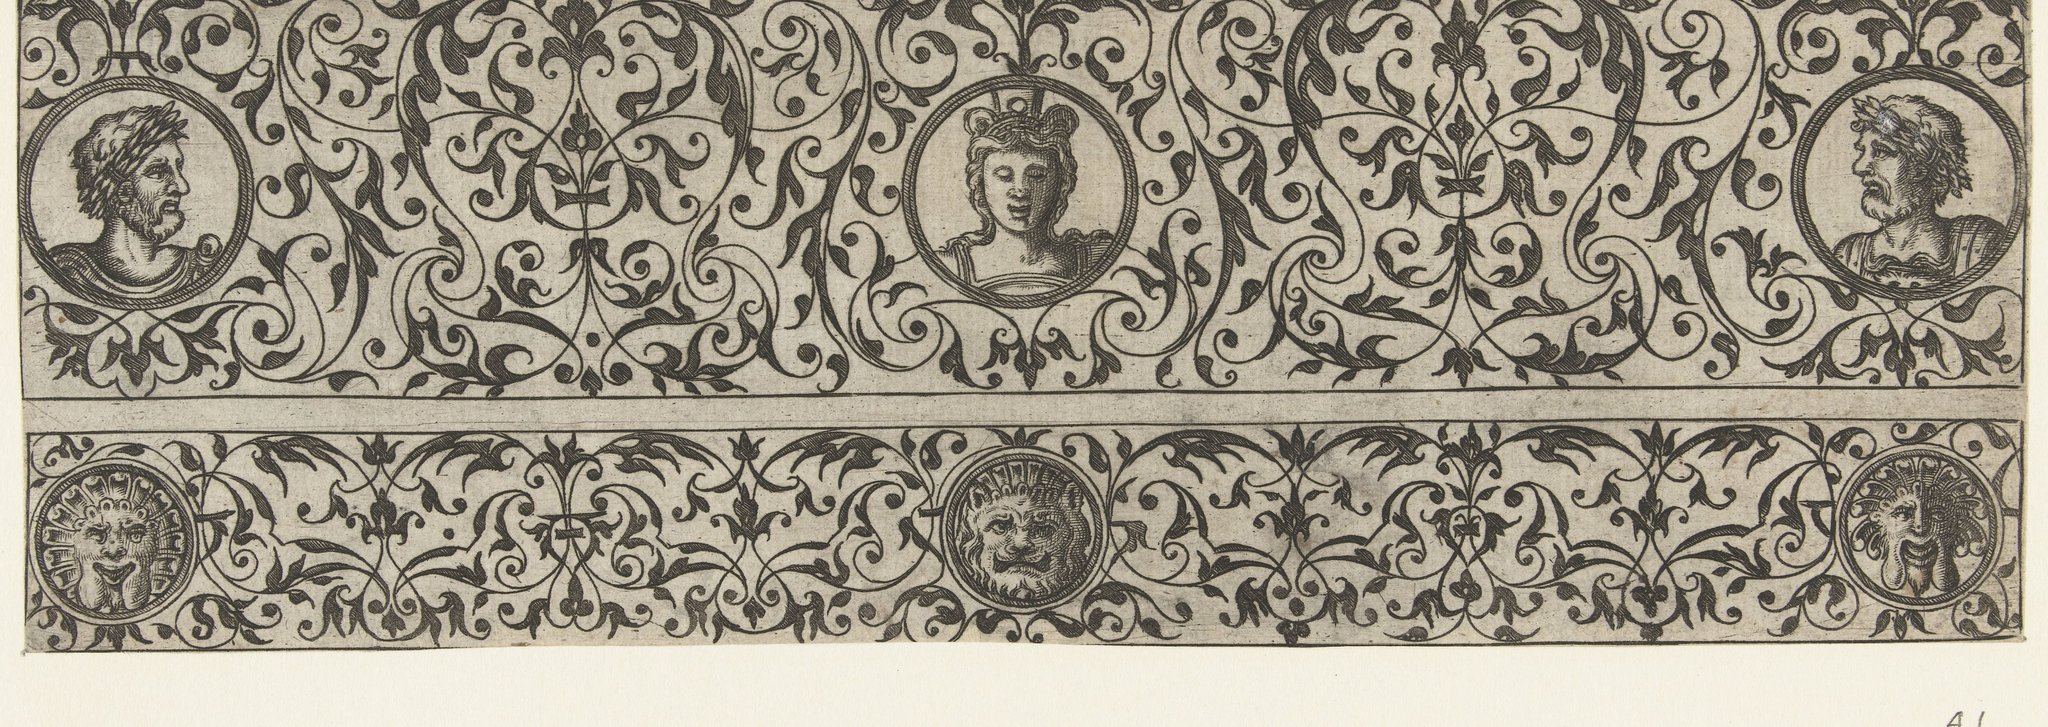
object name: print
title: Variarum protractionum quas vulgo maurusias vocant (...)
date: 1550-1580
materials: paper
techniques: engraving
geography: netherlands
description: Midden in het bovenste fries zit een medaillon met het hoofd van een vrouw, aan elk uiteinde een medaillon met het hoofd van een man met een krans op. Een van 15 bladen afkomstig uit een serie van 23 met titelblad.